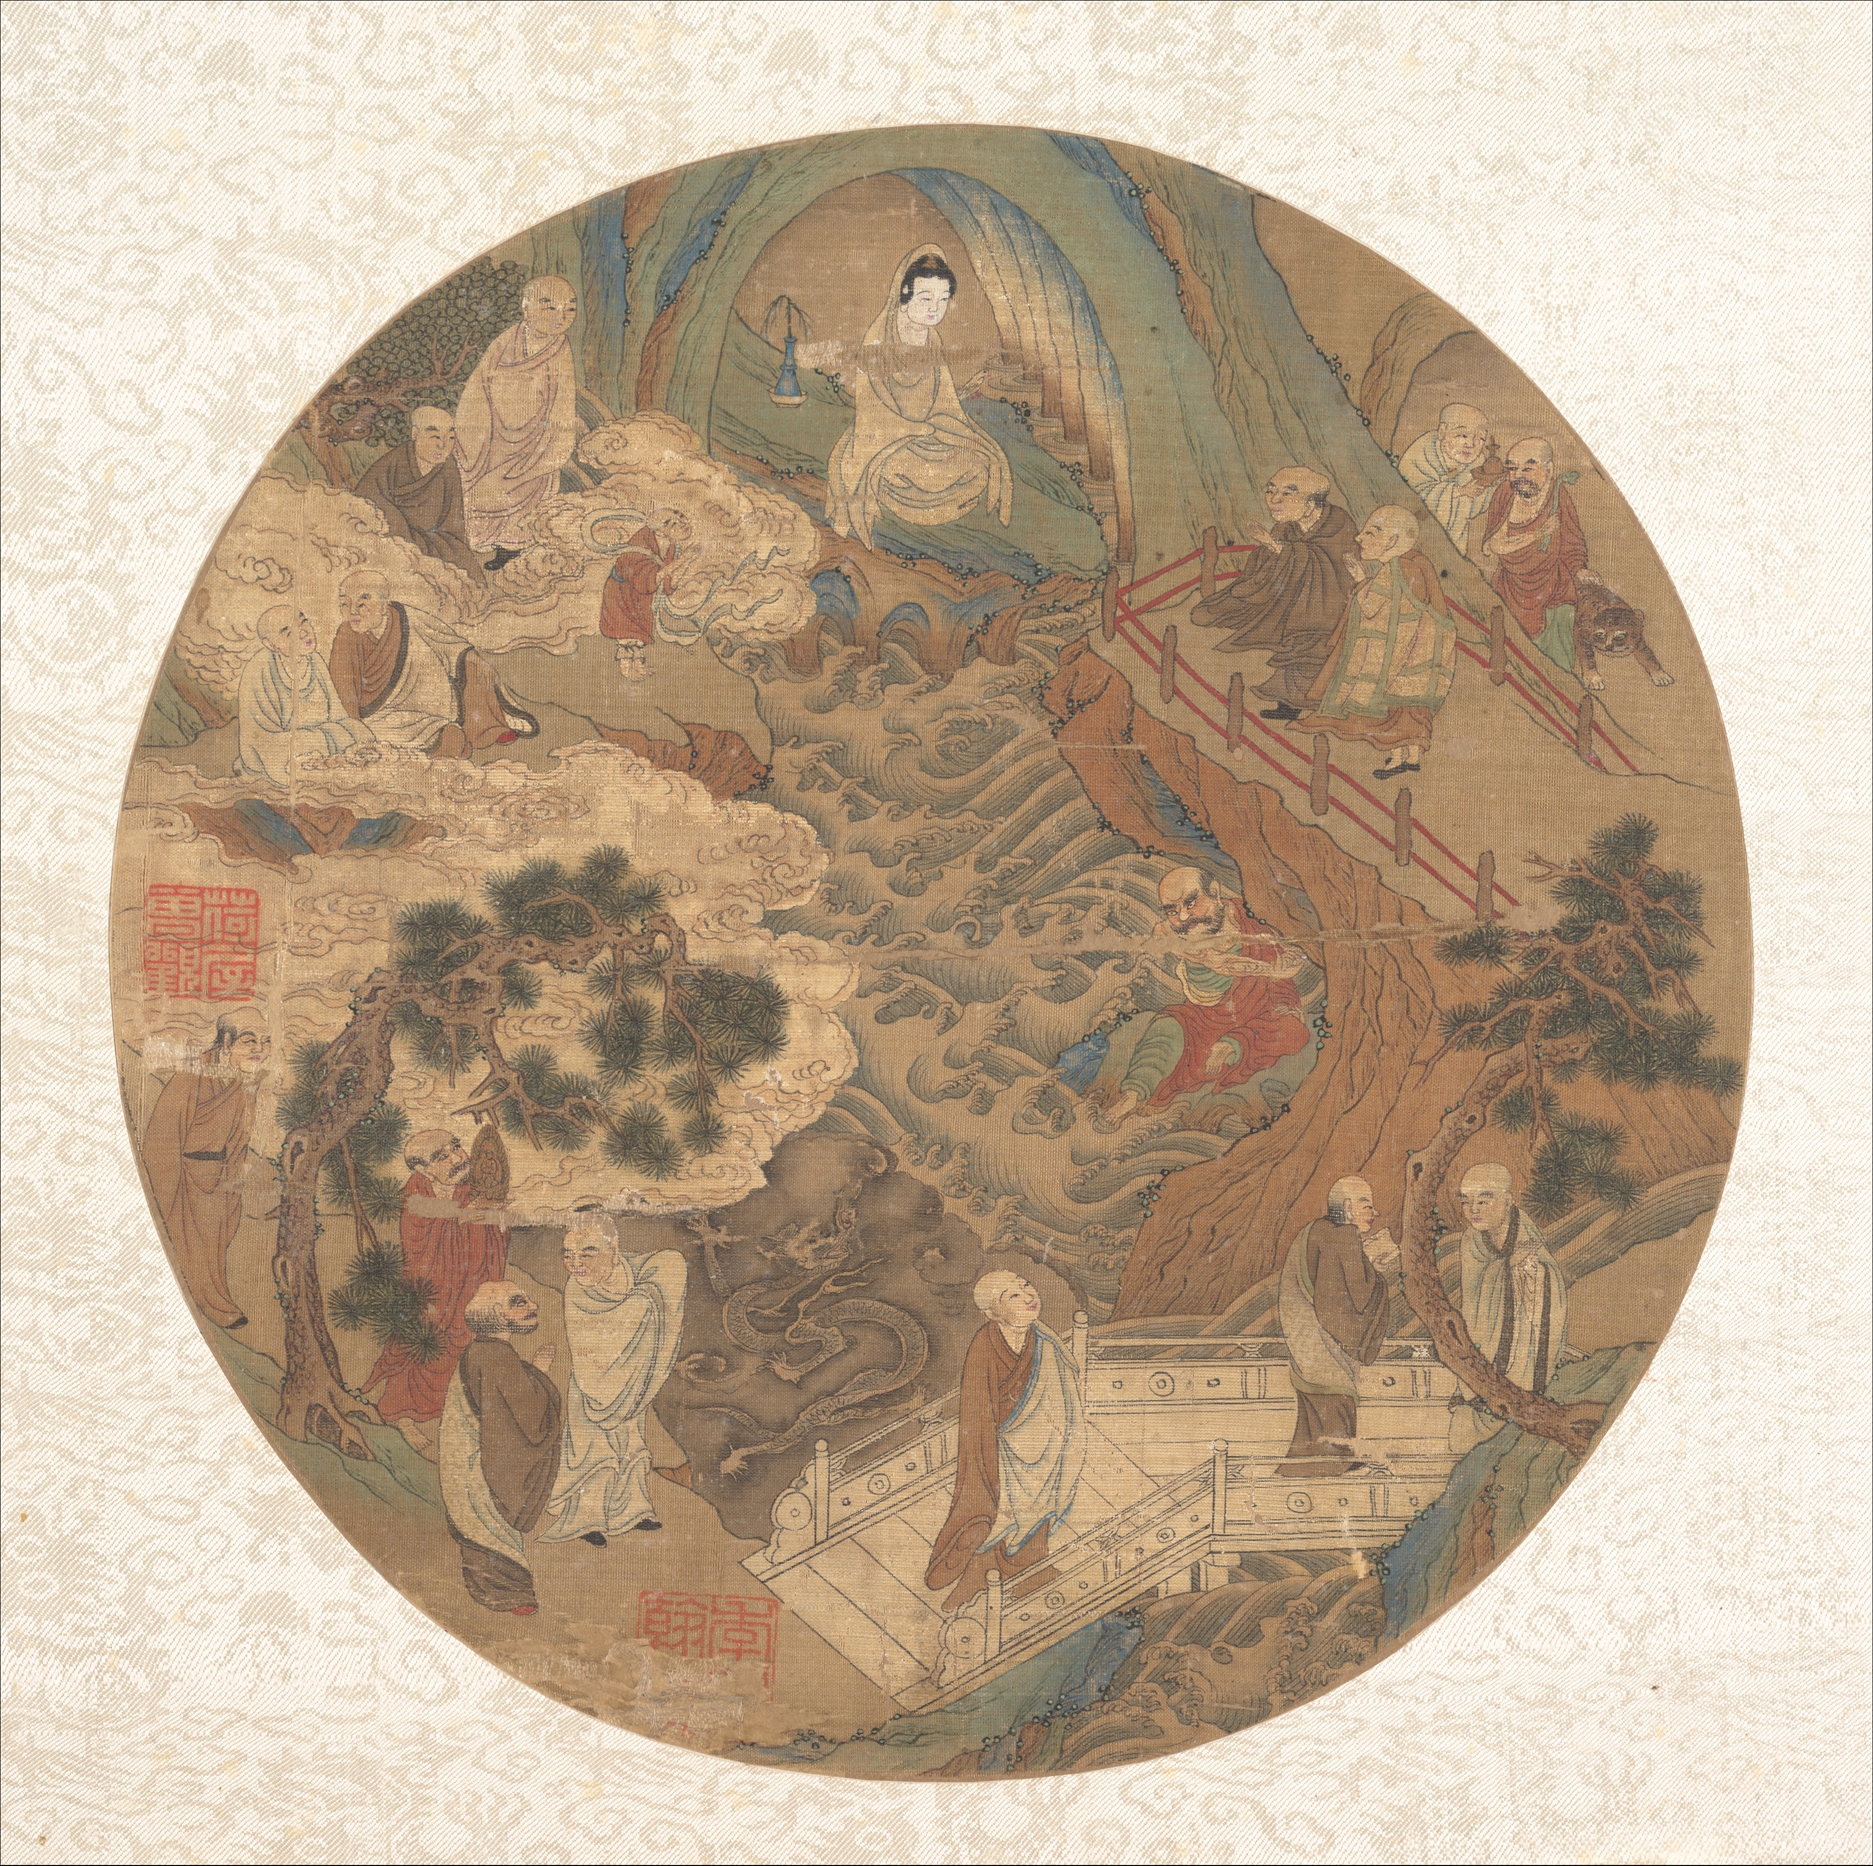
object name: fan mounted a an album leaf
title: Guanyin and the sixteen luohans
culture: chinese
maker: unidentified artist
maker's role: artist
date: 1501-1700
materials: gold, ink, silk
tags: bridges,men,women,buddhism,bodhisattvas